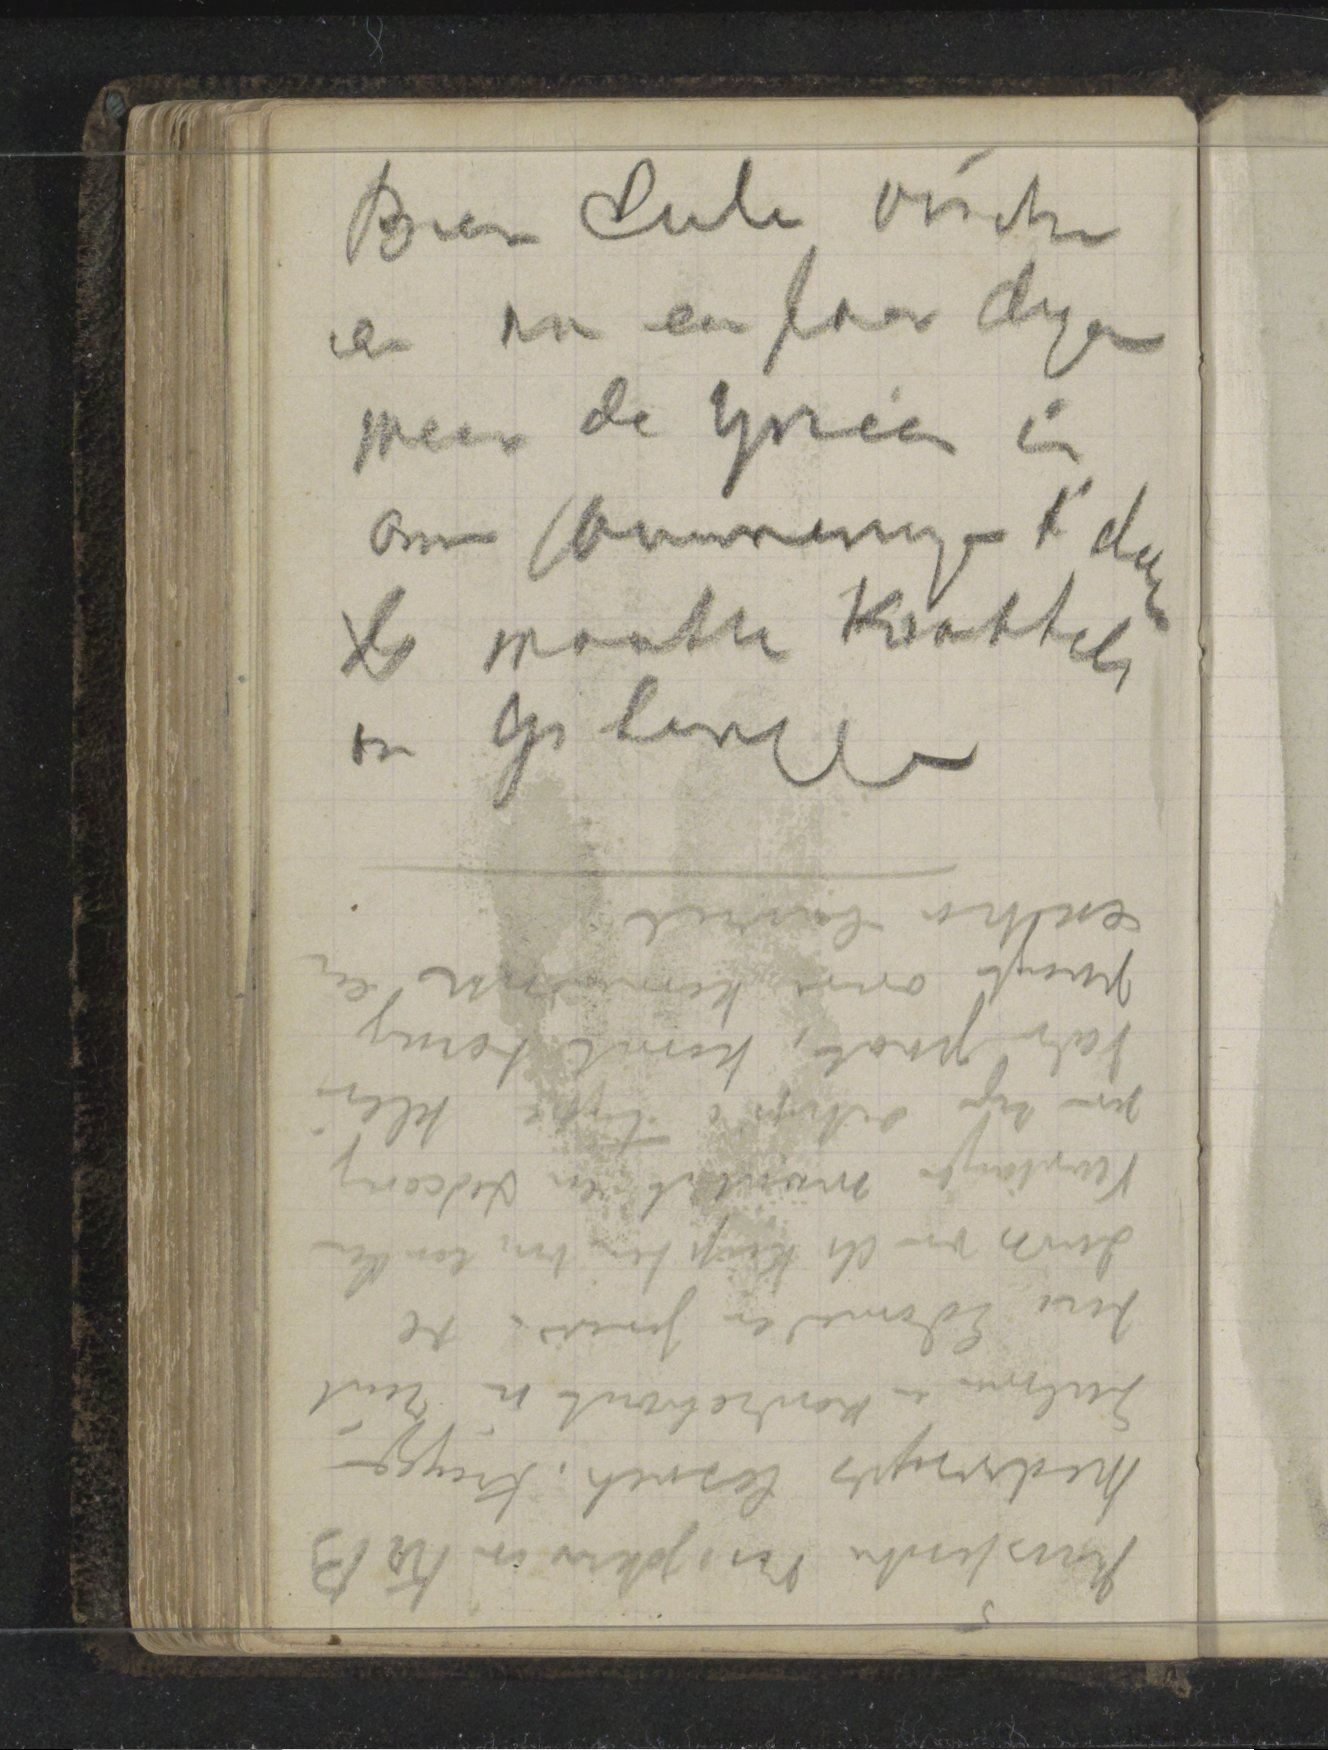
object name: sketchbook leaf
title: Reisverslag van medio juli 1880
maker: louis apol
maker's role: draughtsman, painter, print maker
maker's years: 1850-1936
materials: chalk, pencil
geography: vardø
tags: vardø, nova zembla expedities 1880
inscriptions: annotation: ‘[...]’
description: Blad 63 verso uit een schetsboek met 110 bladen betekend tijdens de expeditie naar Nova Zembla in 1880.